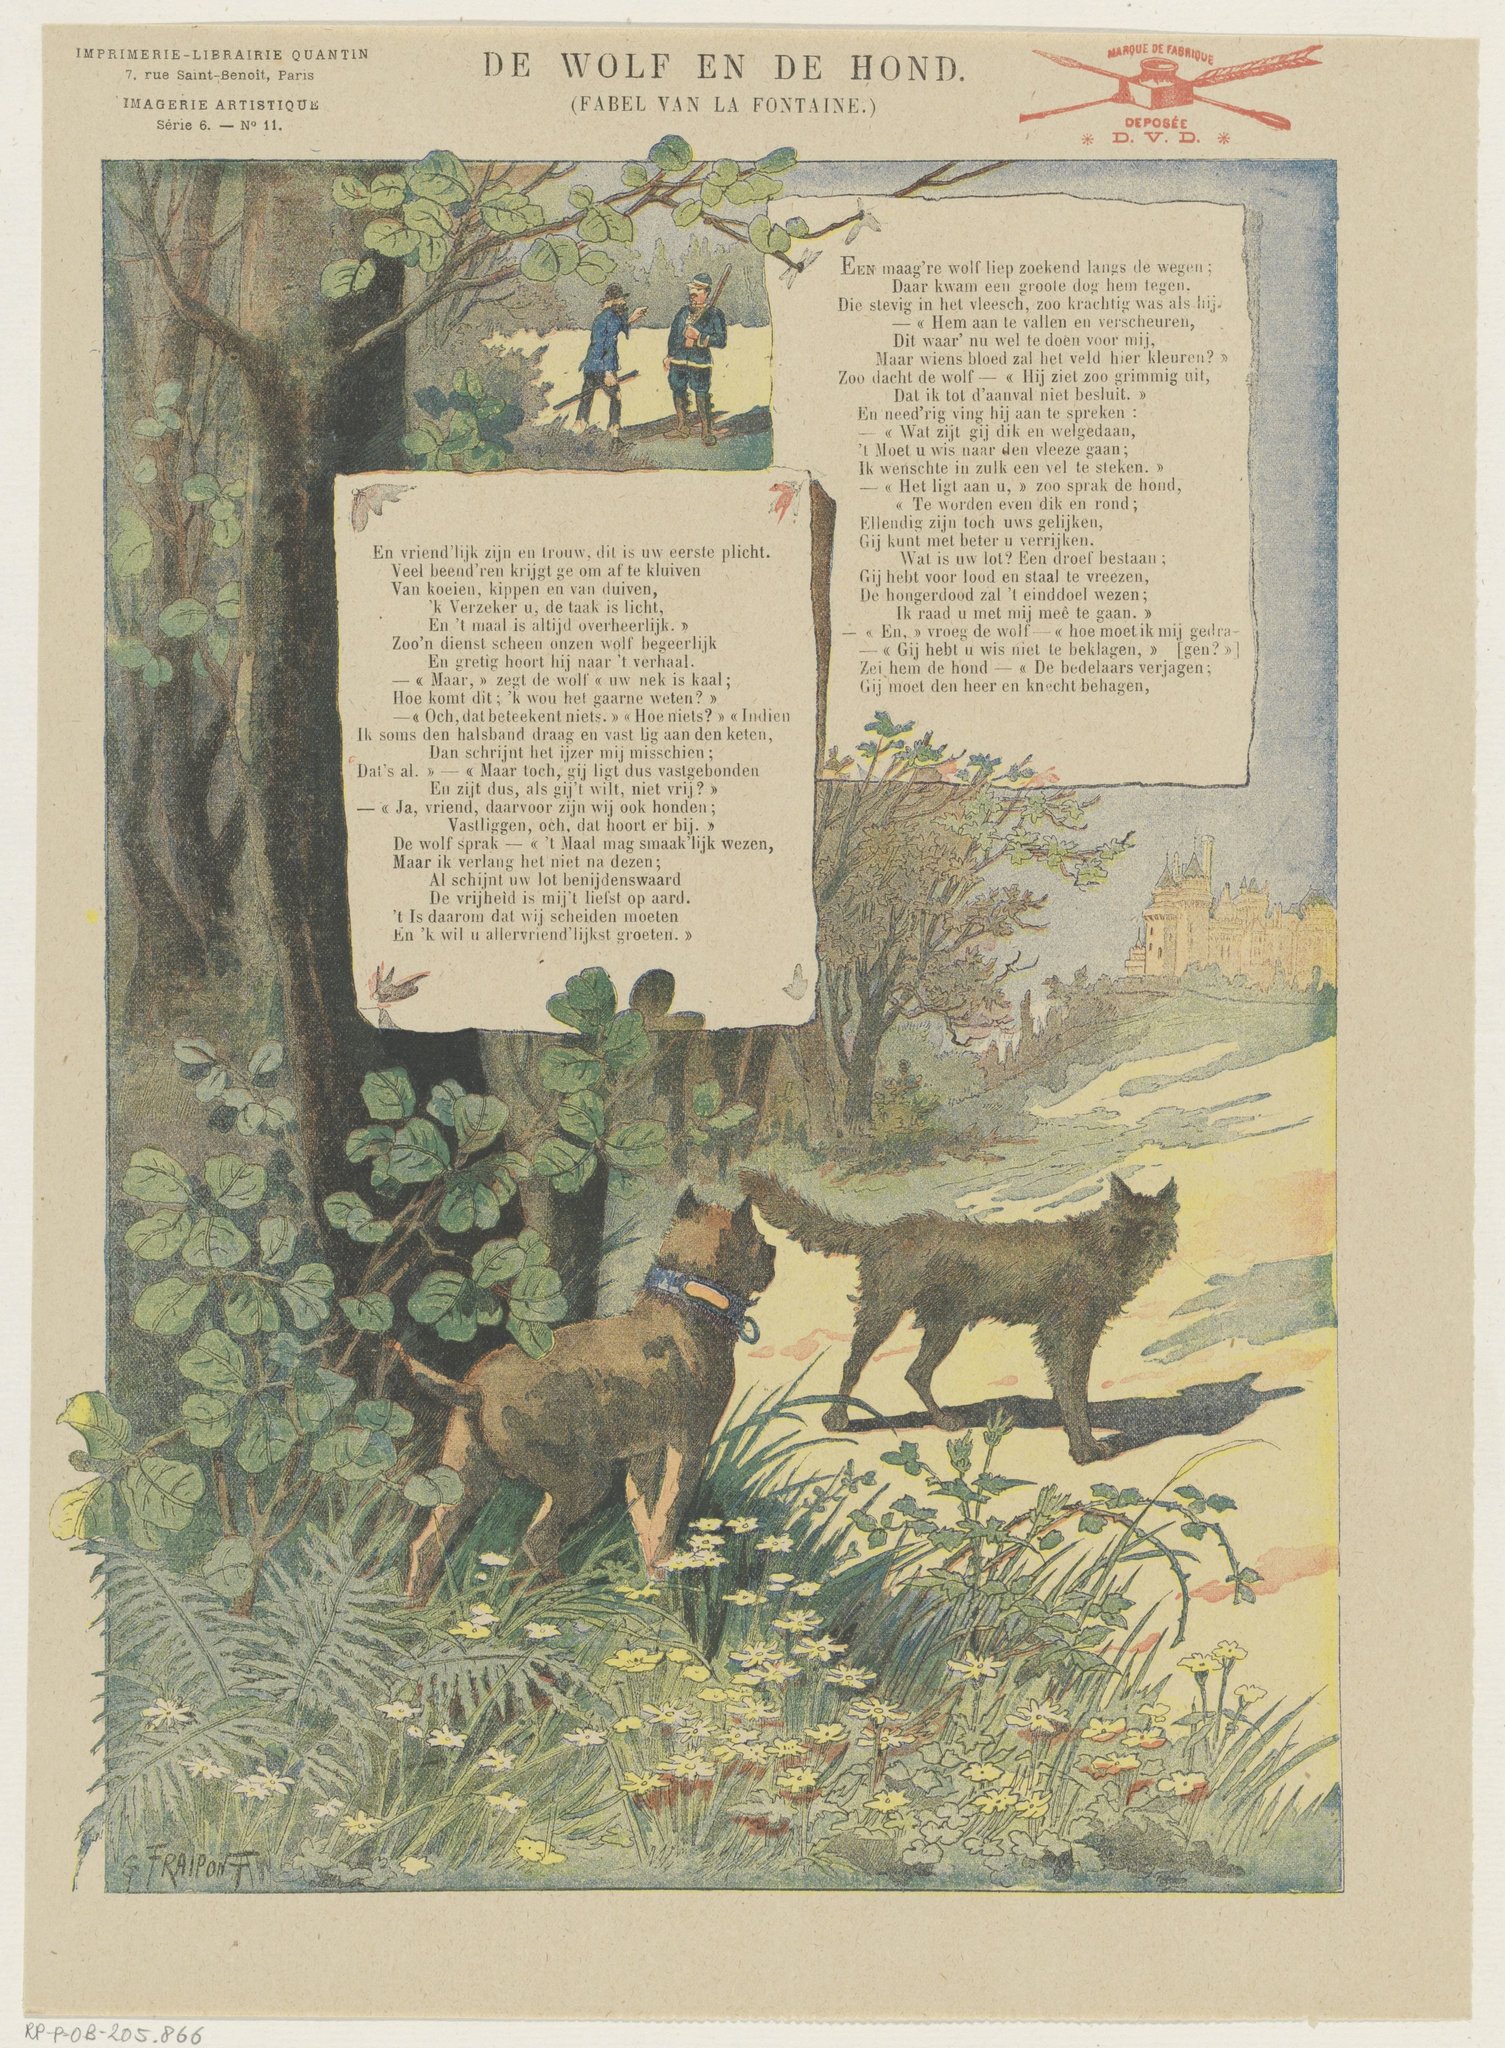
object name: print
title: Imagerie Artistique / Série 6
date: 1876-1890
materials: paper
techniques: lithograph, letterpress printing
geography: paris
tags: fables, dog, beasts of prey, predatory animals: wolf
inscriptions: collector's mark: Lugt 2760, : ‘marque de fabrique / deposée / * D.V.D. *’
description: Blad met een grote voorstelling uit de fabel van Jean de La Fontaine, van de wolf en de hond. Midden boven twee tekstblokken met een vers. Genummerd linksboven: Série 6. - No. 11.